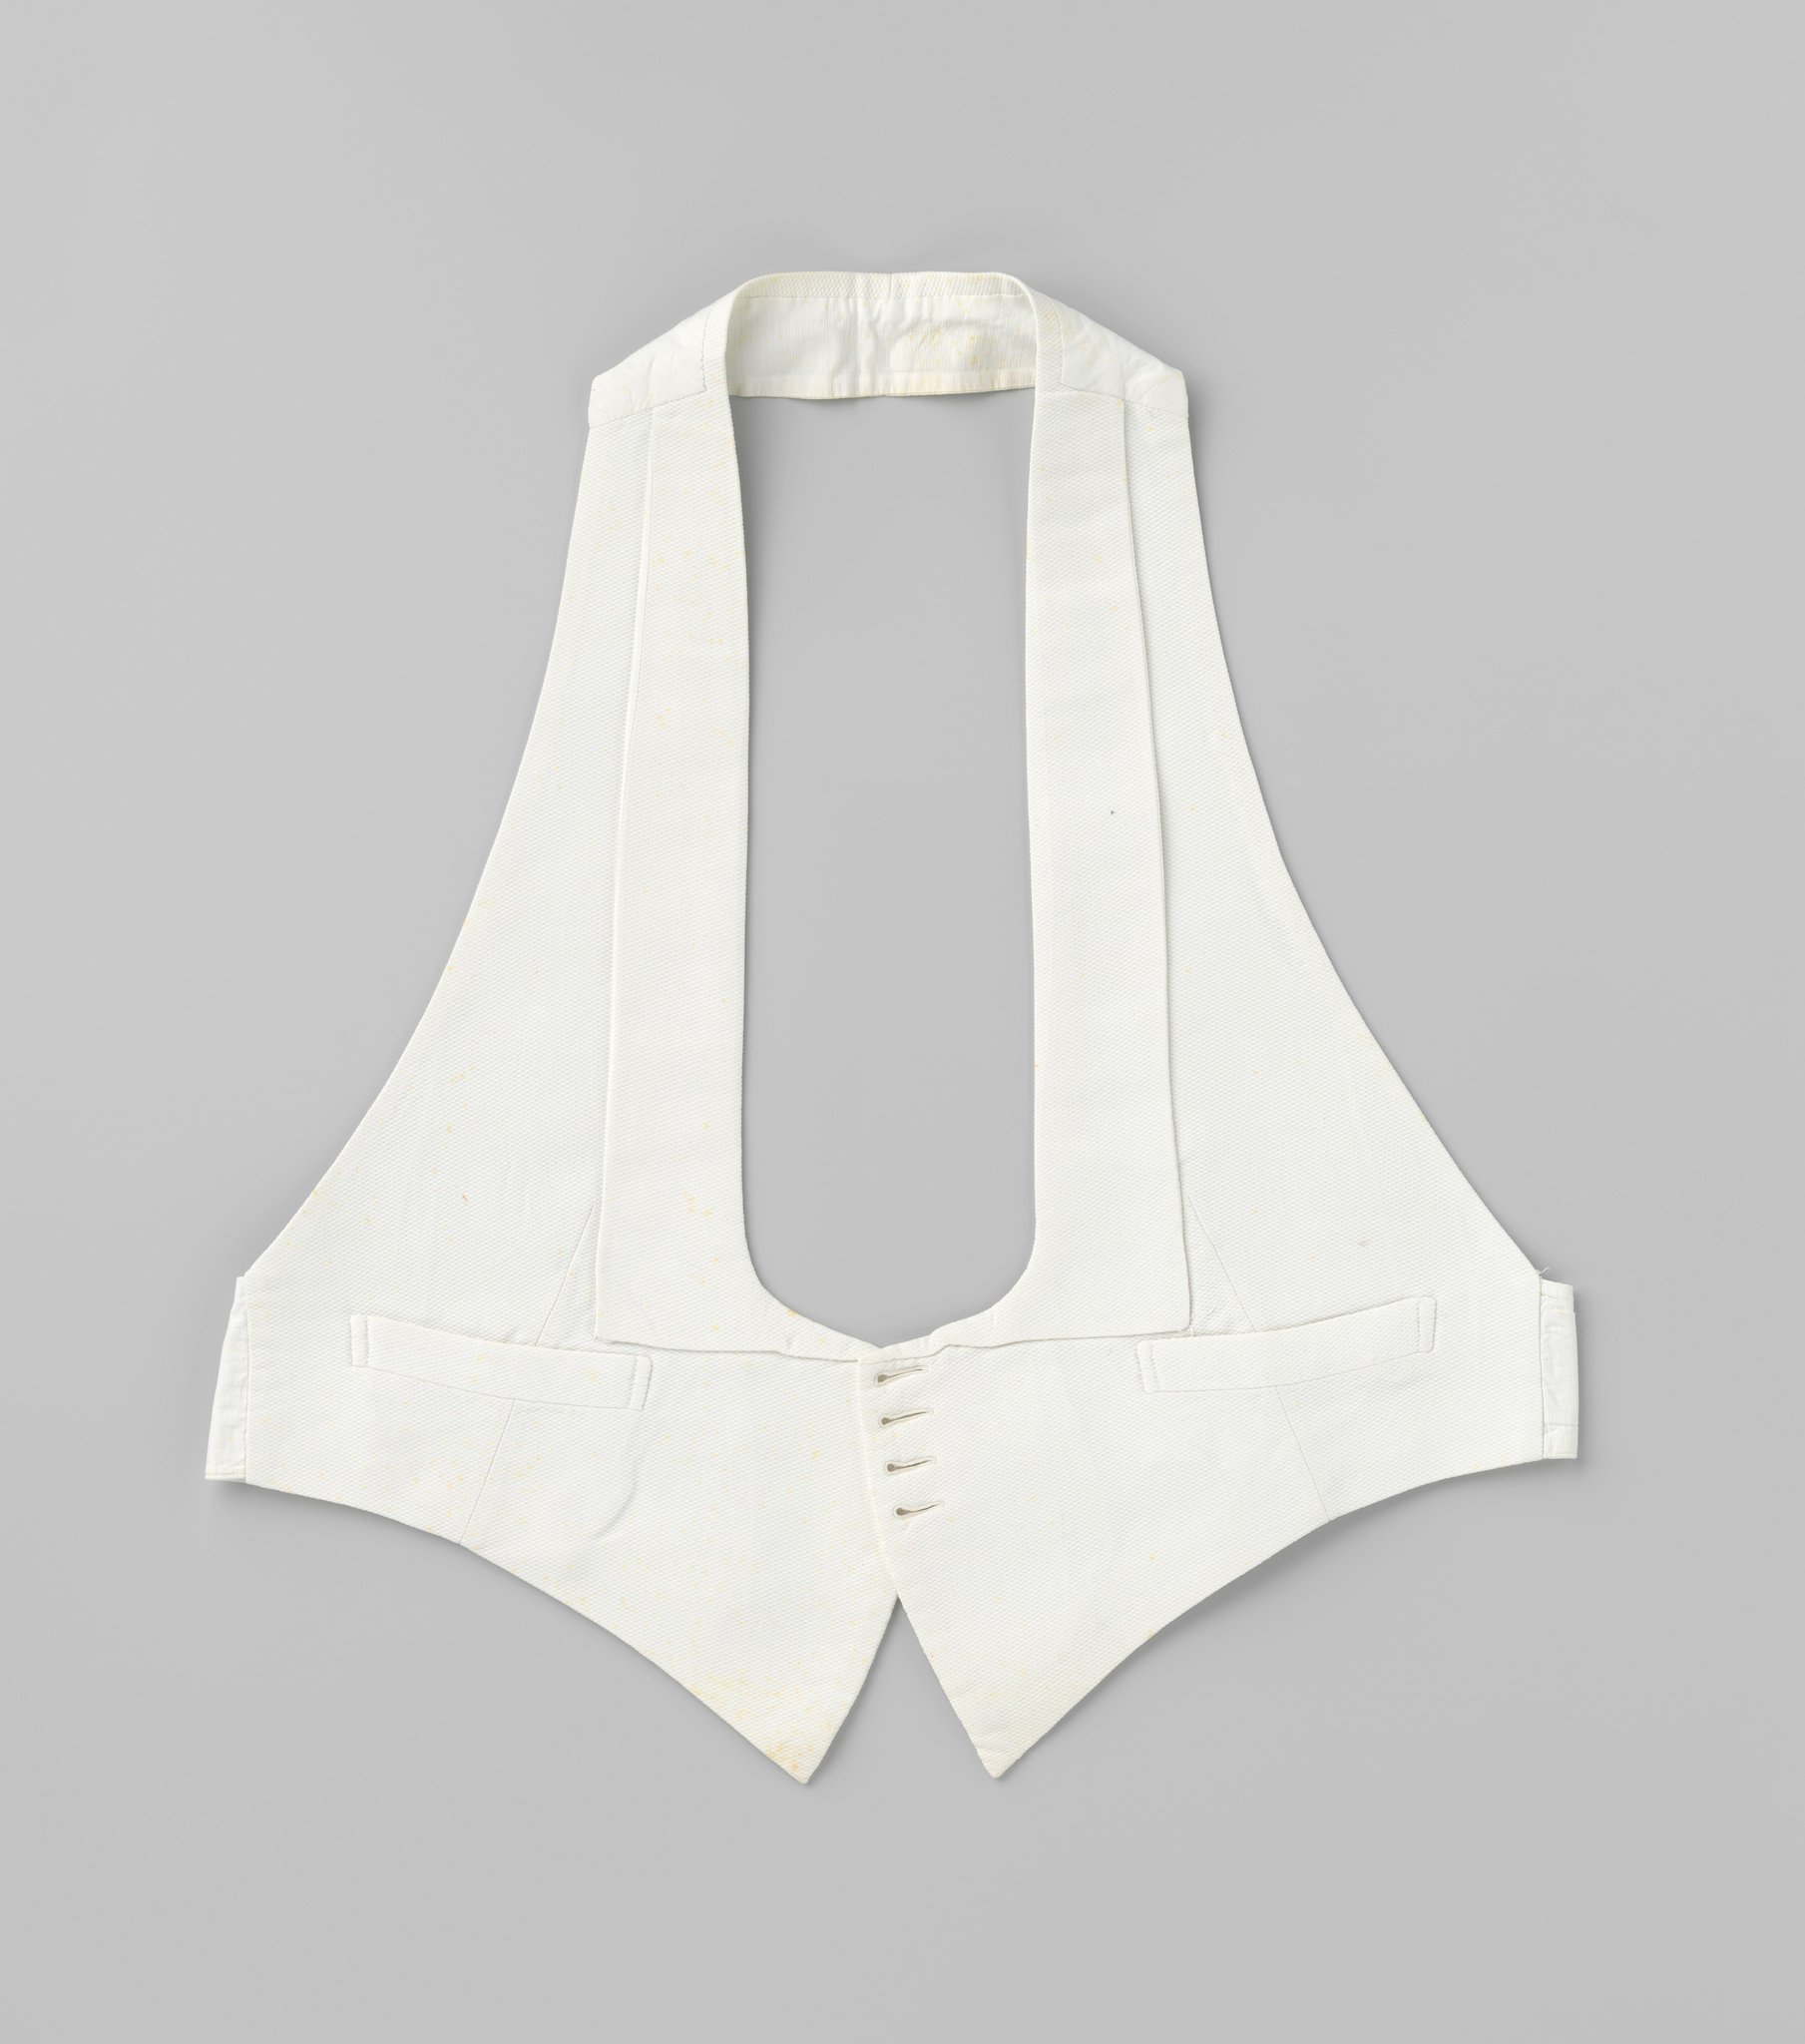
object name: waistcoat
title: Wit gilet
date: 1850-1920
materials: textile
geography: london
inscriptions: label: ‘HenryPOOLE&Compy / Nos 37,38,39, SAVILLE ROW, LONDON / No.’